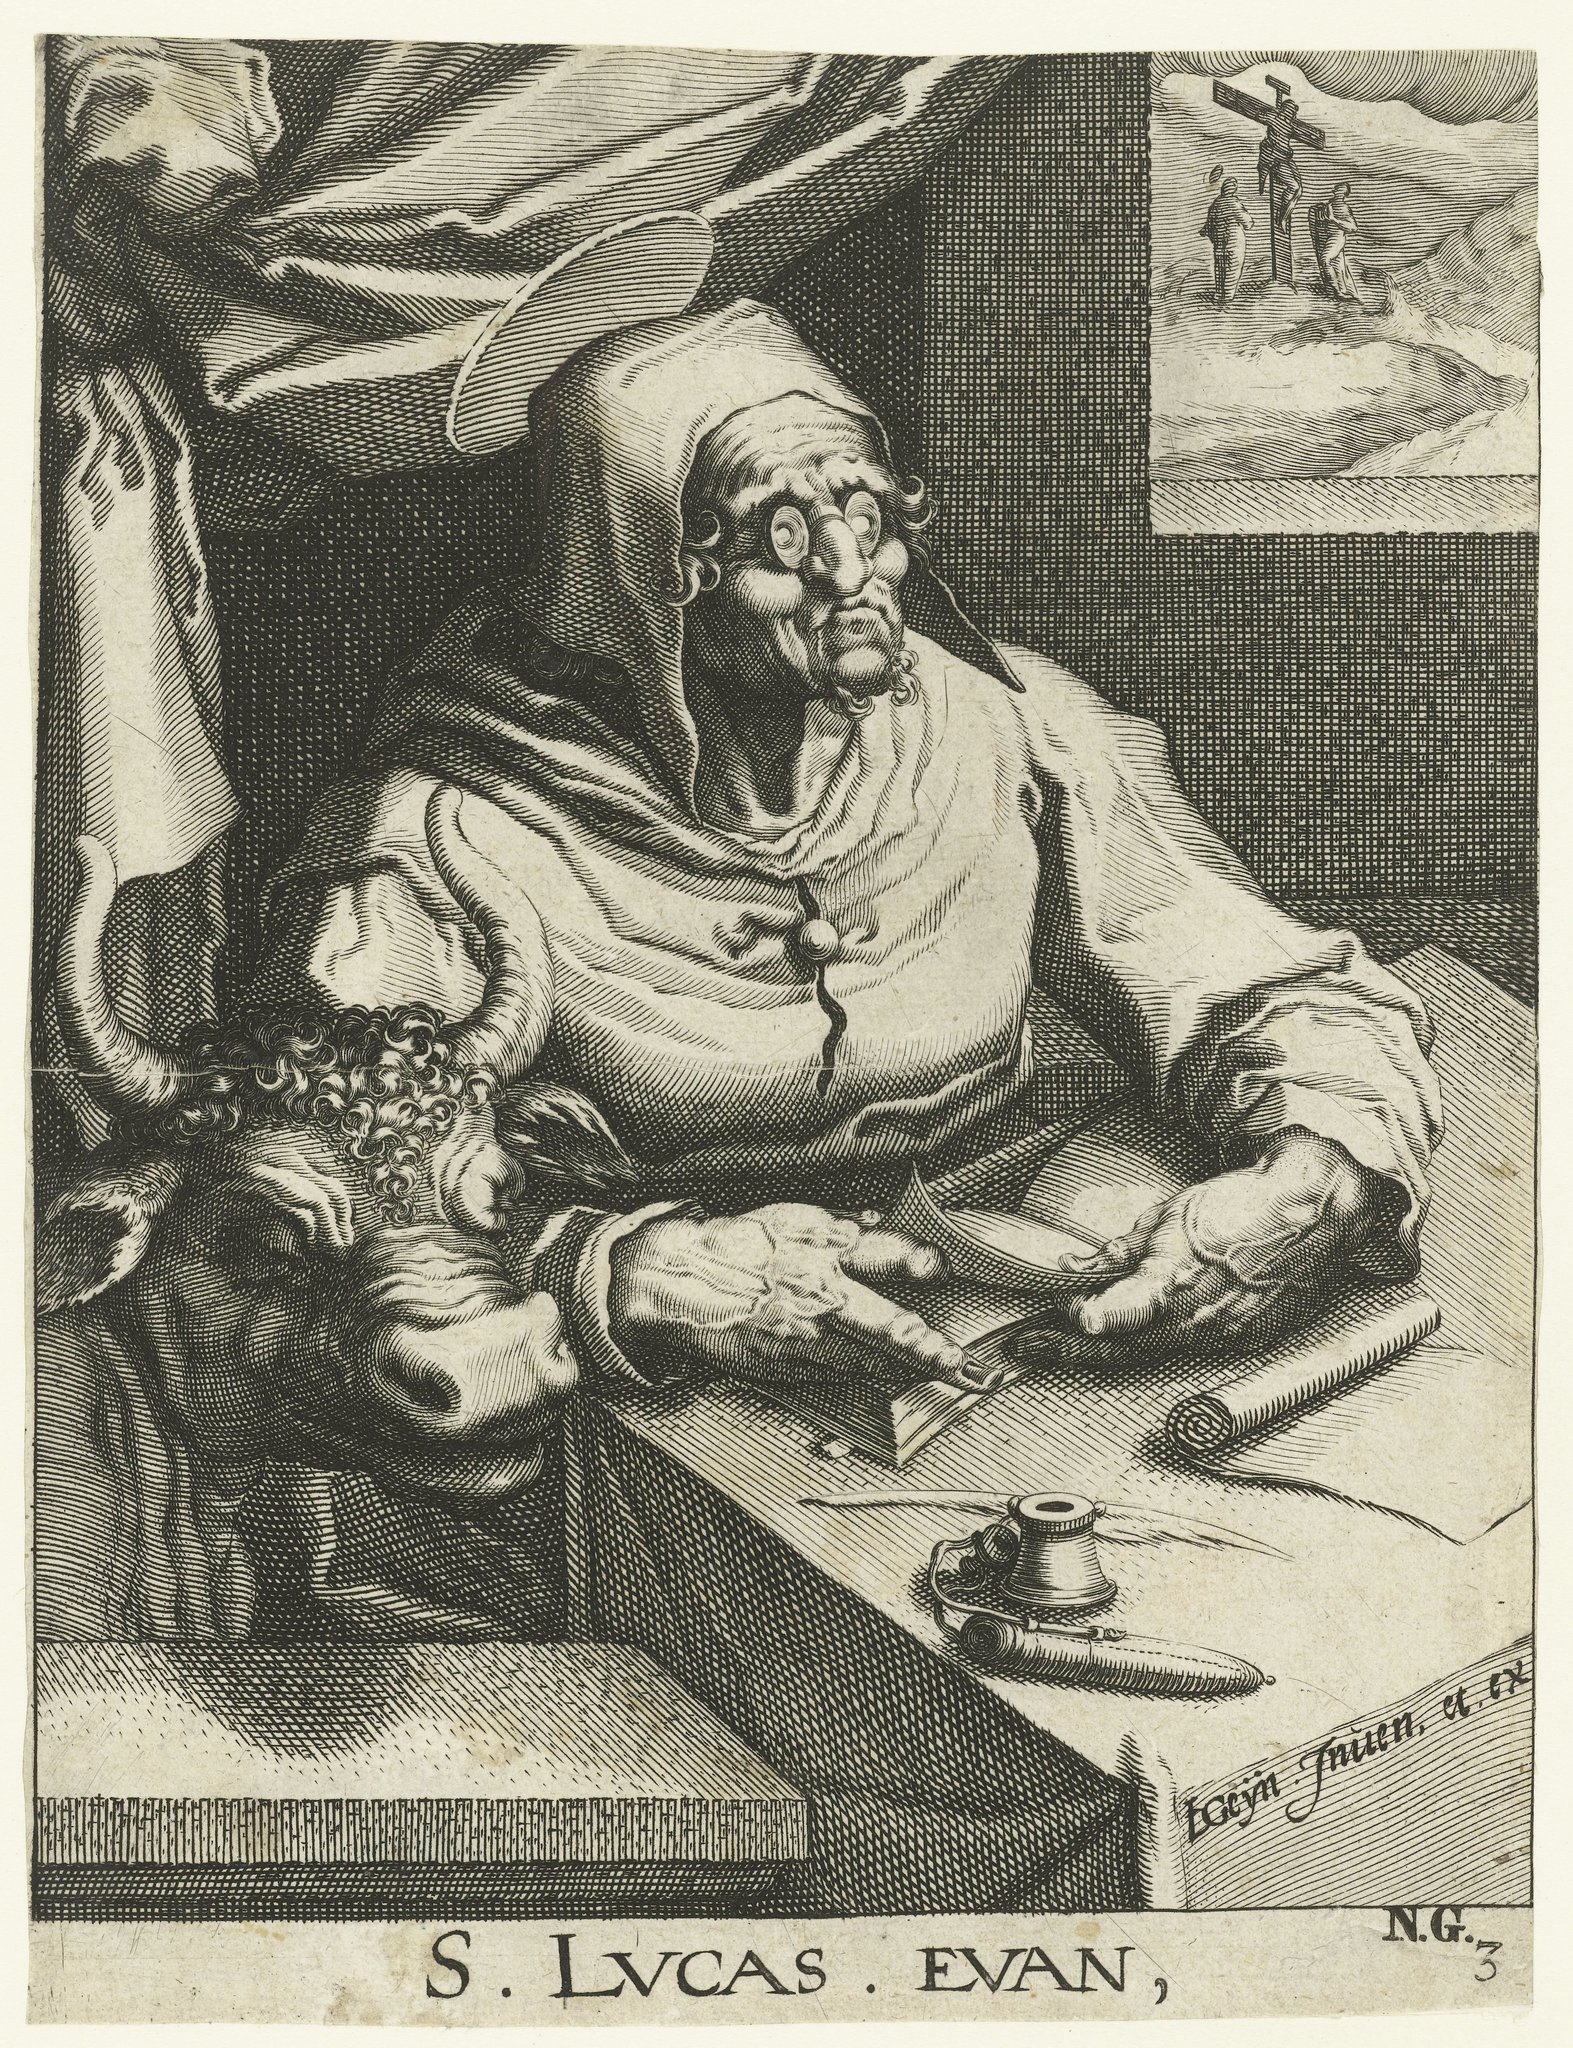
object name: print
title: Evangelist Lucas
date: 1593-1597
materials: paper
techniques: engraving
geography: leiden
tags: luke the evangelist; possible attributes: book, (winged) ox, portrait of the virgin, surgical instruments, painter's utensils, scroll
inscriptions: collector's mark: Lugt 2228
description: Lucas de evangelist, gezeten, een boek in de handen. Een rund staat bij zijn rechterzijde. Onder de voorstelling de tekst 'S. Lvcas. evan,'. Deze prent is onderdeel van een serie van vier voorstellingen van de evangelisten, elk met de naam van de betreffende evangelist als onderschrift.